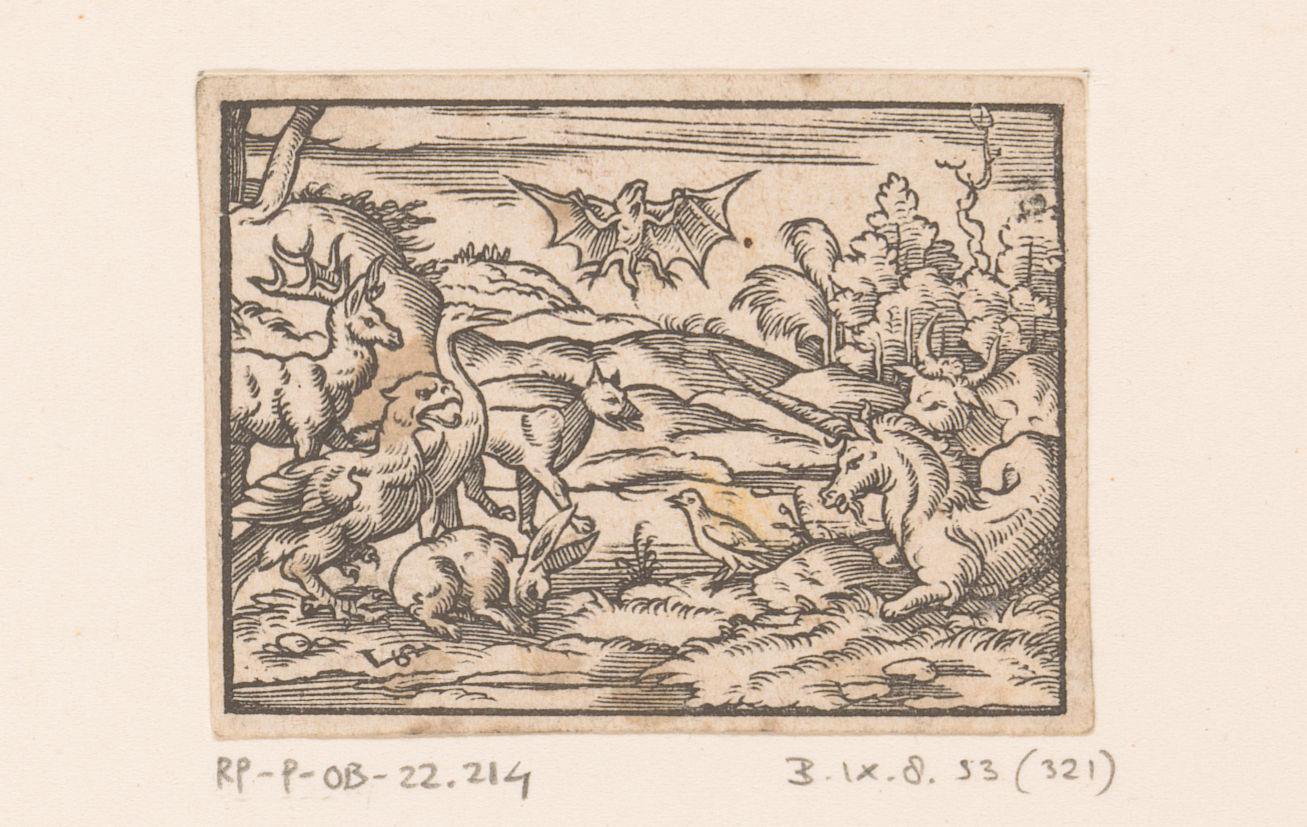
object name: print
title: Fabel van de vleermuis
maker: virgilius solis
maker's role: draughtsman, print maker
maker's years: 1514-1562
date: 1566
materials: paper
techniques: woodcut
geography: nuremberg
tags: flying mammals: bat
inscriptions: number: ‘184’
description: Illustratie bij de Fabels van Aesopus, onder meer gebruikt voor de publicatie: Posthius, Johann. Aesopi Phrygis Fabulae. Frankfurt am Main: Sigmund Feyerabend, Georg Rab en erven Weigand Han, 1566.